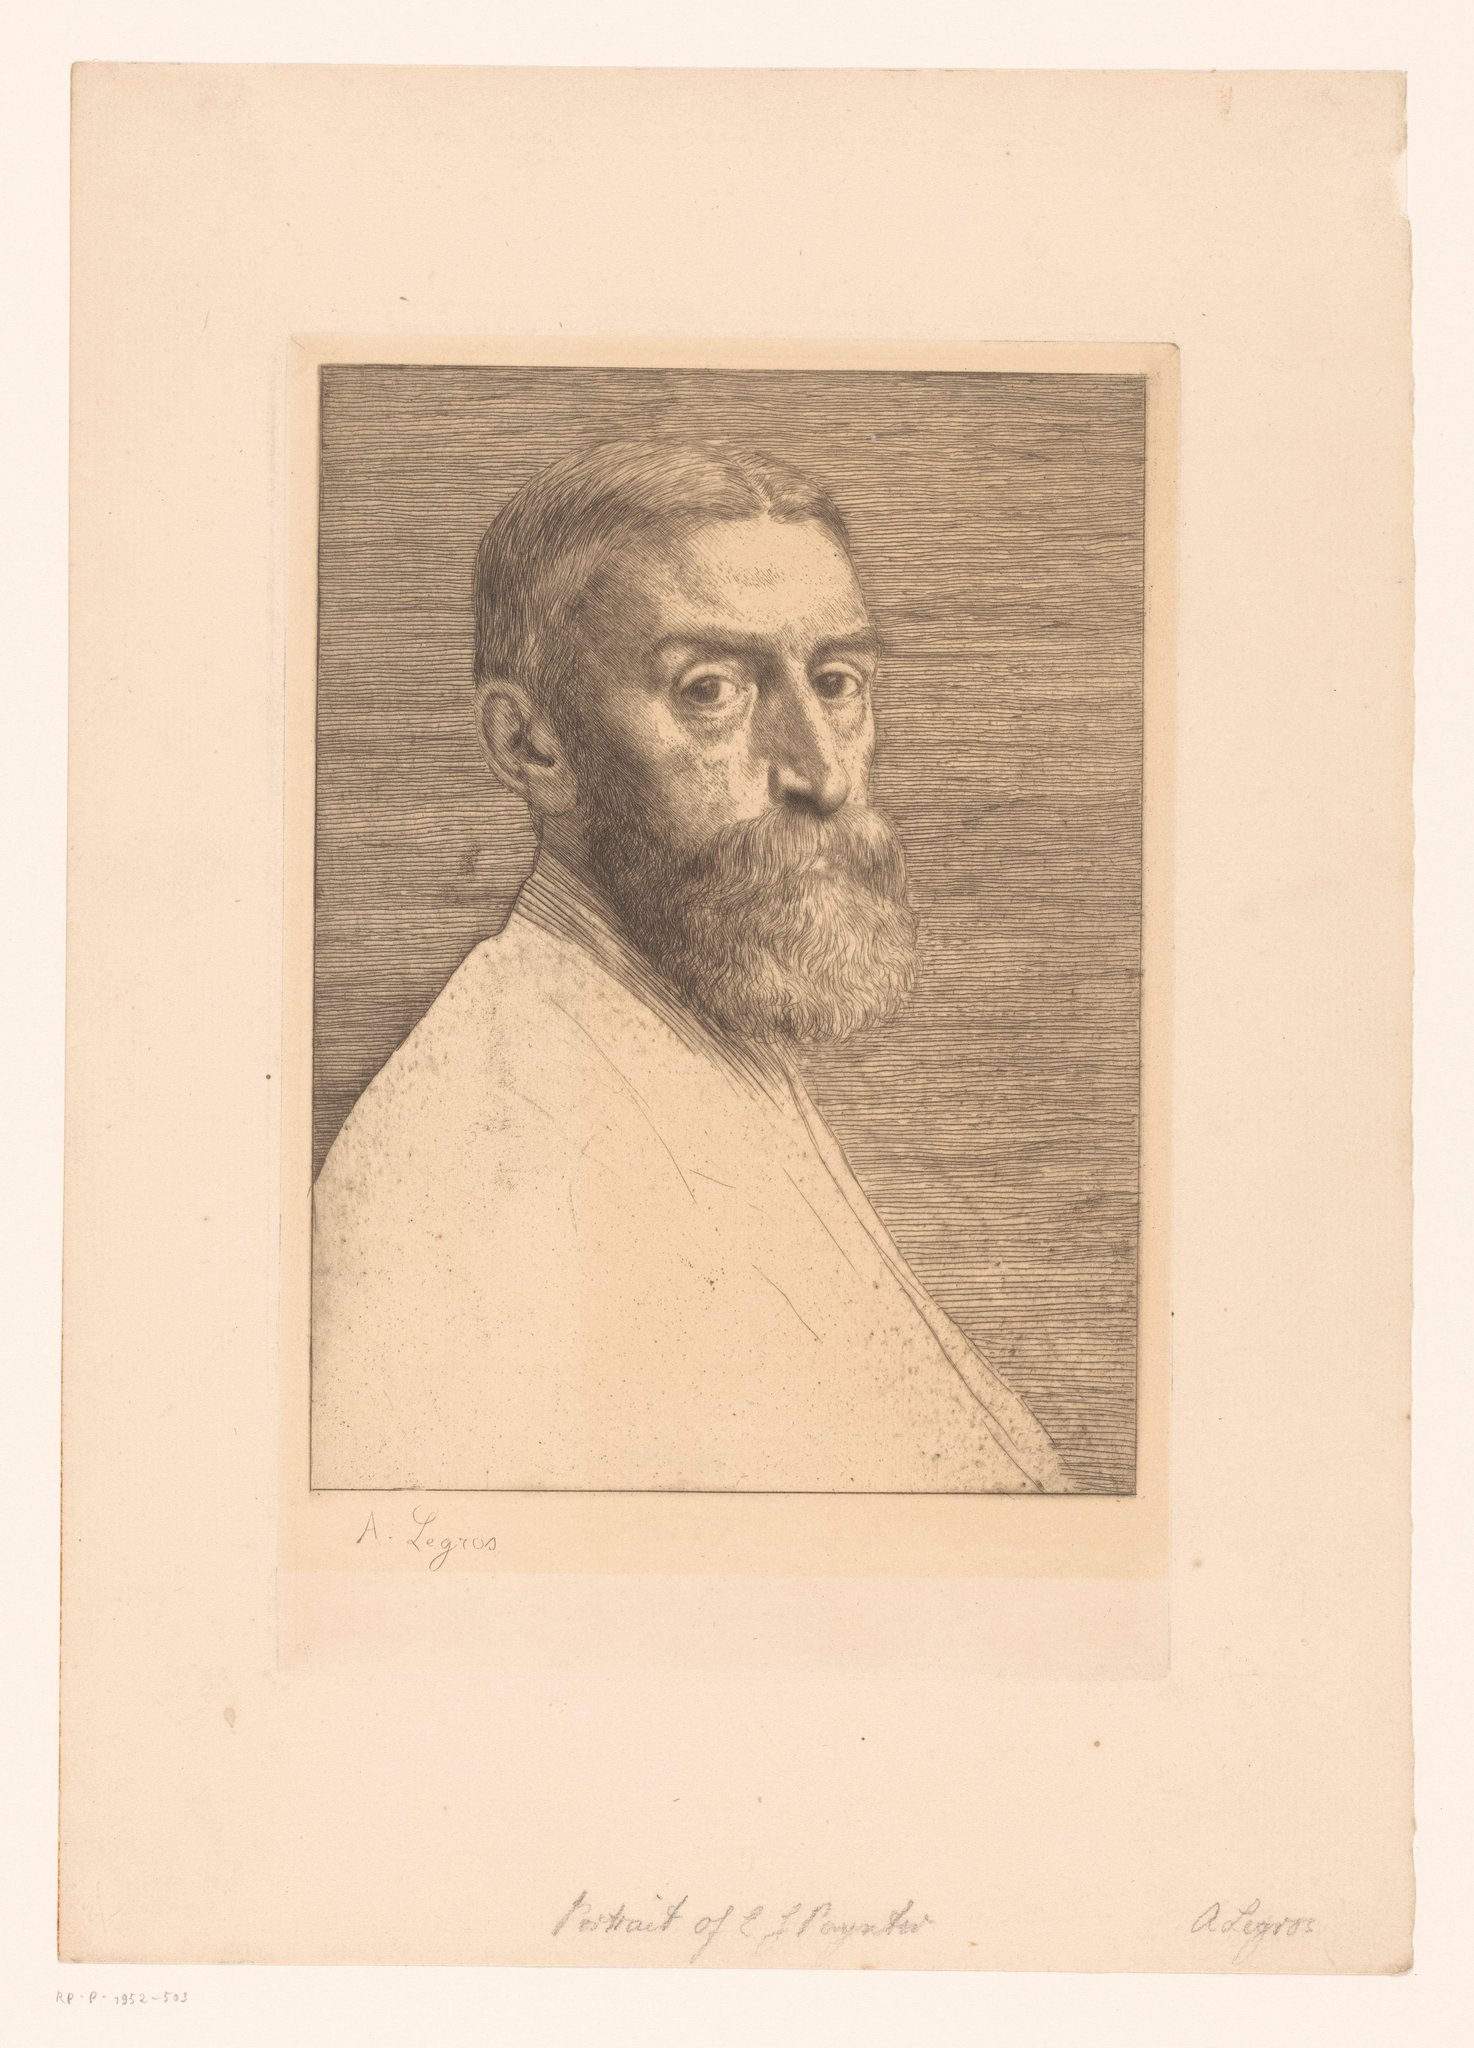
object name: print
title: Portret van Edward Poynter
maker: alphonse legros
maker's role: print maker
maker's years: 1837-1911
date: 1877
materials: paper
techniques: drypoint, etching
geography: france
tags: paris, london, draughtsman, edward john poynter (sir), historical persons, portrait, self-portrait of artist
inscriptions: collector's mark: Lugt 2228